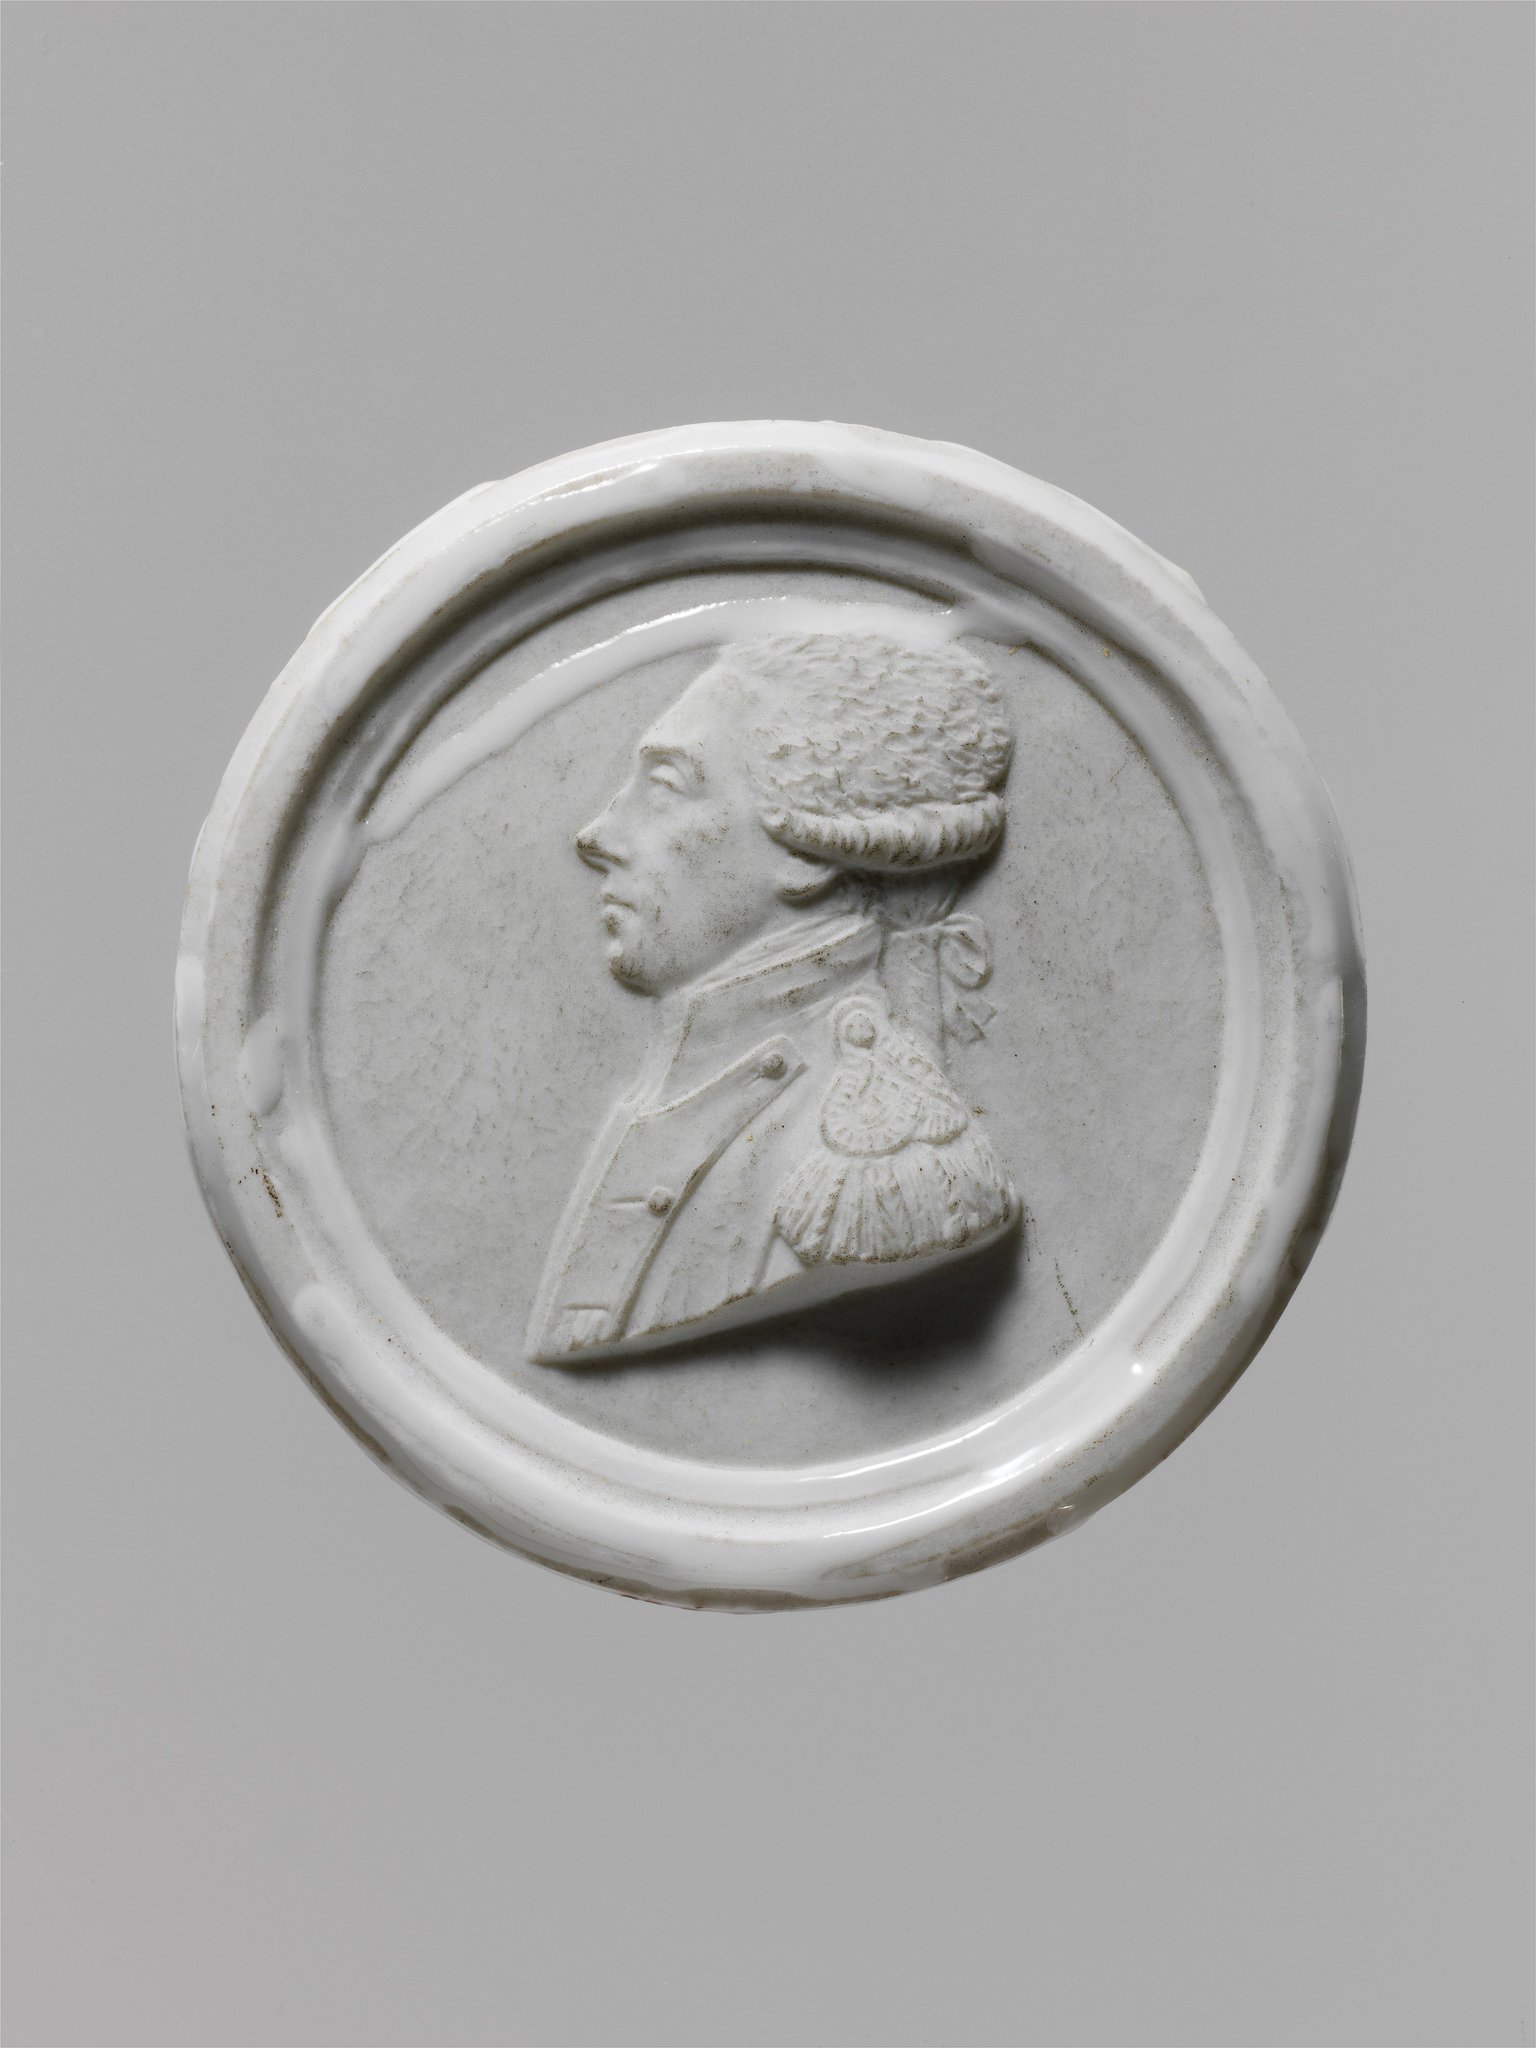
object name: medallion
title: Medallion of the Marquis de Lafayette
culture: french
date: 1775-1883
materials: porcelain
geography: france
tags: men,profiles,marquis de lafayette